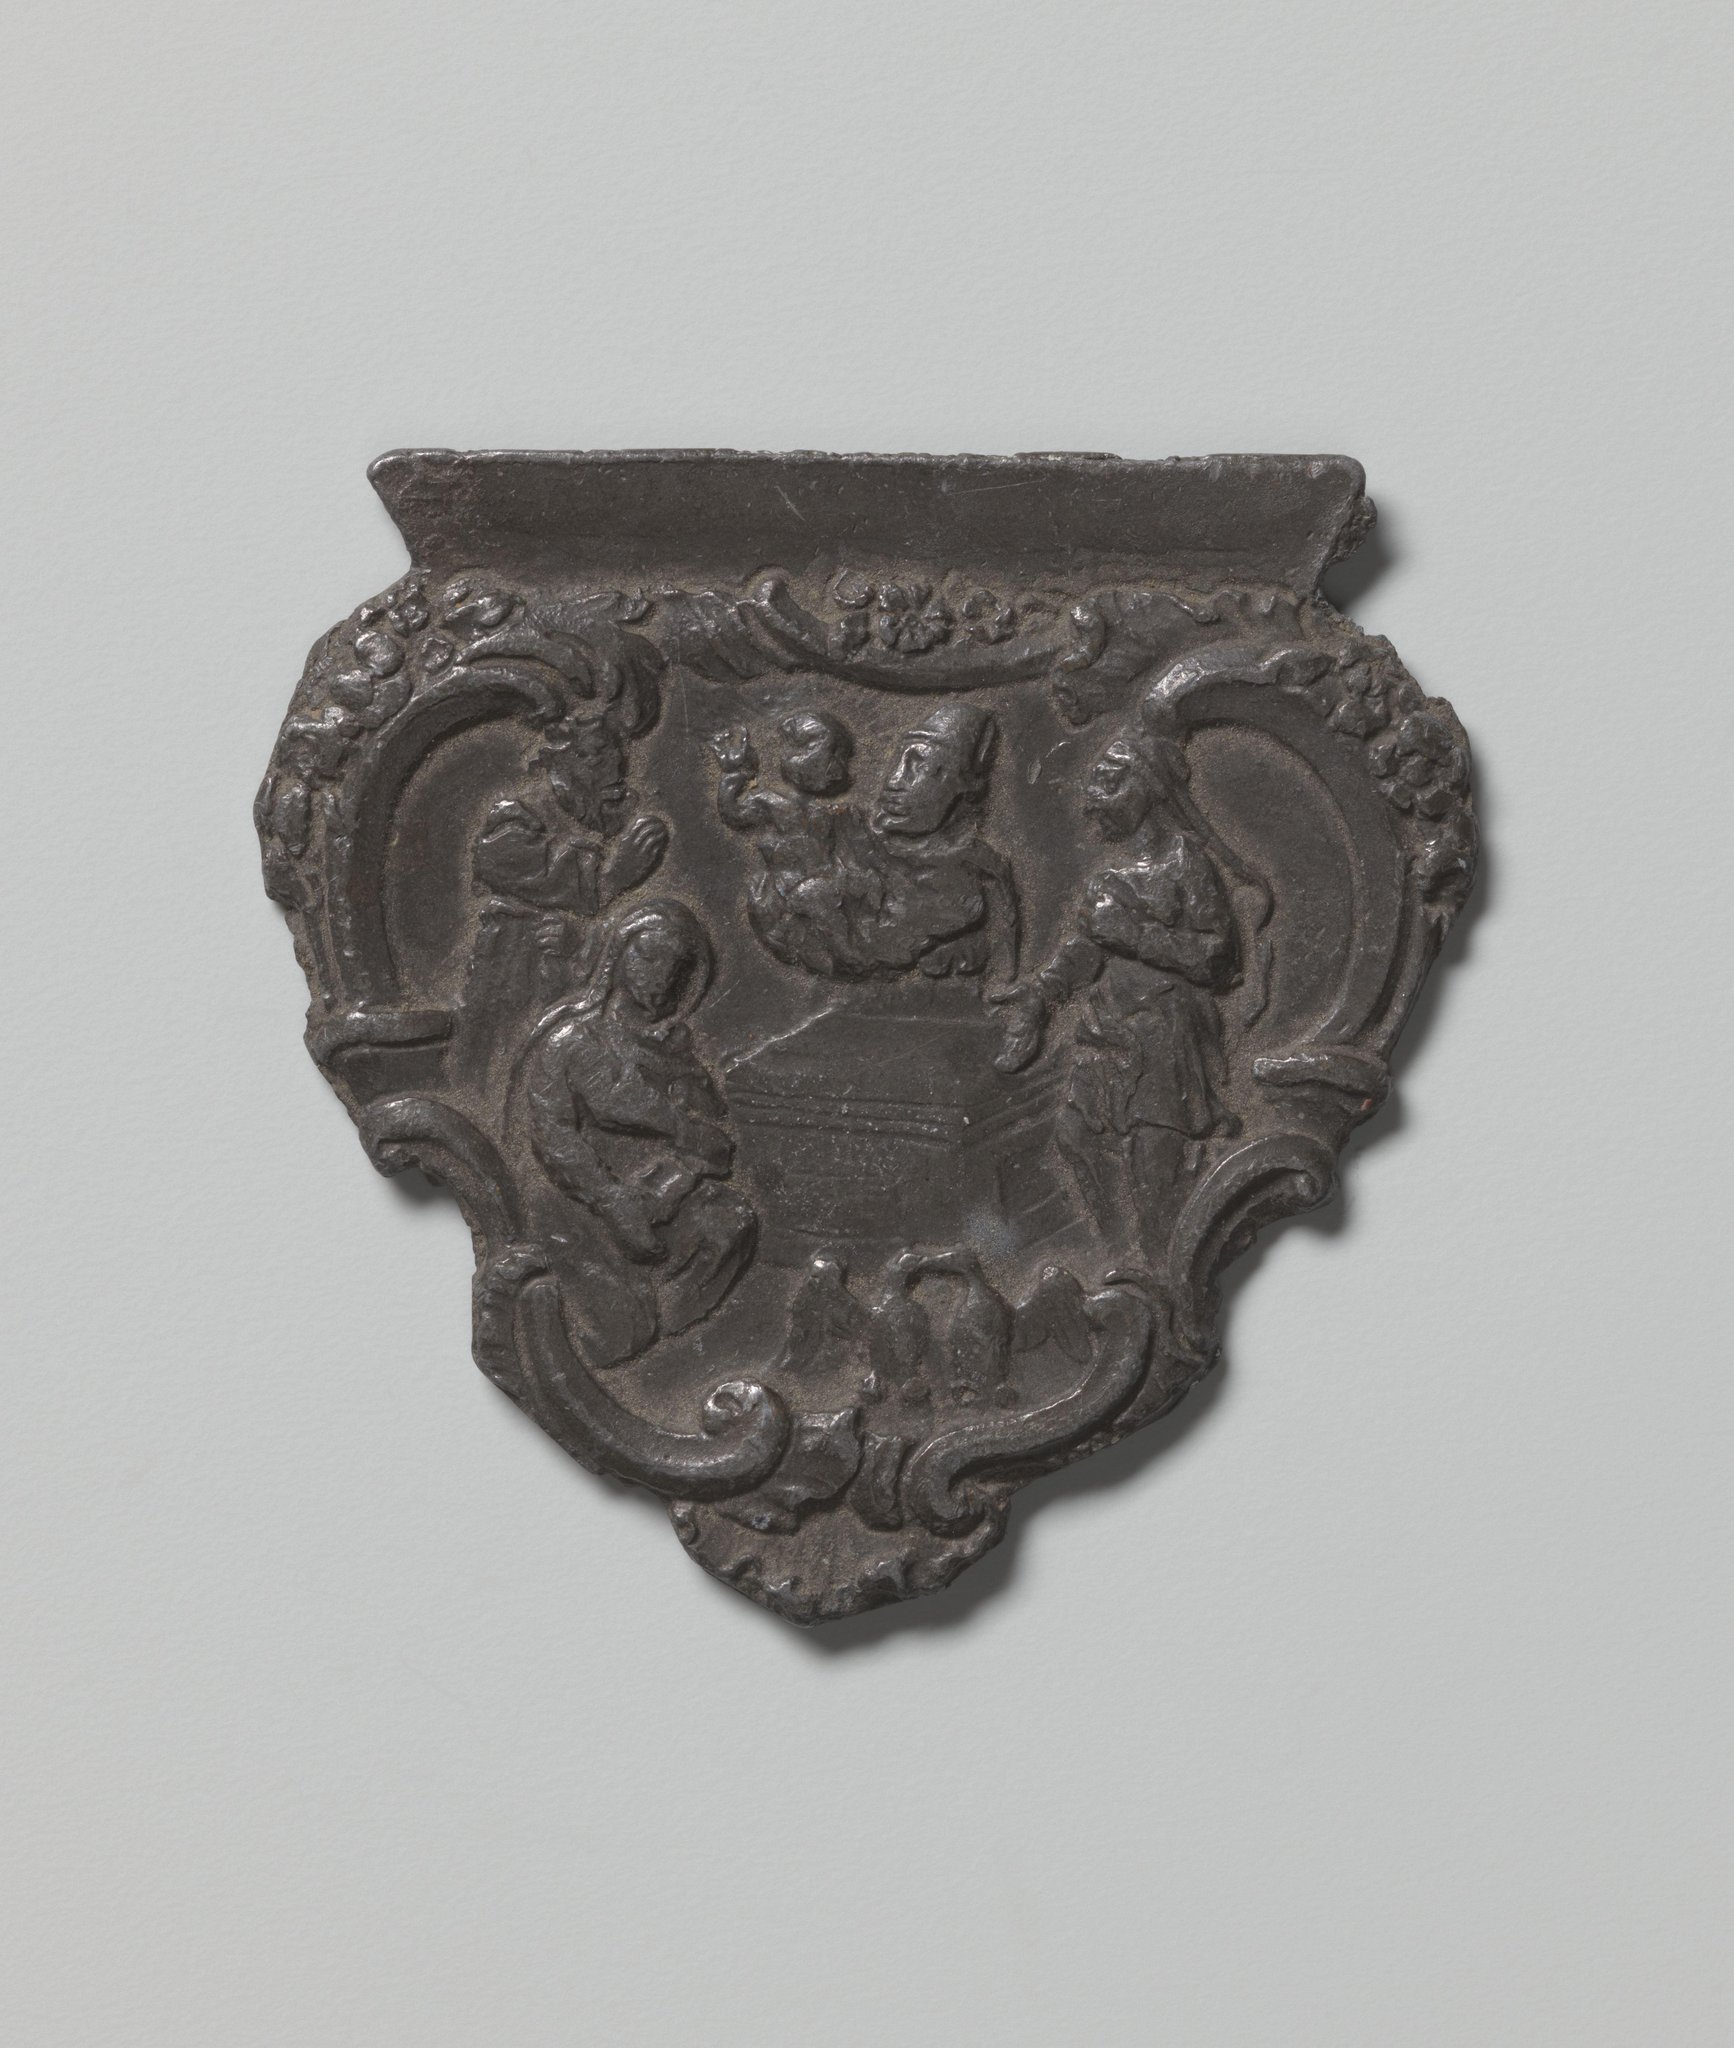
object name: model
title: Model voor een klamp van een boekslot met de priester Simeon met het Christuskind, Maria, Josef en de profetes Anna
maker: Anonymous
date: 1750-1775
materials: tin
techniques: metalworking, cutting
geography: amsterdam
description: Model van tin voor een gietvorm van een klamp van een boekslot. De voorstelling toont de priester Simeon met het Christuskind, links daarvan Jozef en Maria en rechts daarvan de profetes Anna. Het geheel is gevat in een rococo-ornament, gevormd door drie grote, naar binnen gekeerde c-voluten en daartussen twee kleine, naar buiten gekeerde c-voluten. De bovenzijde is recht.